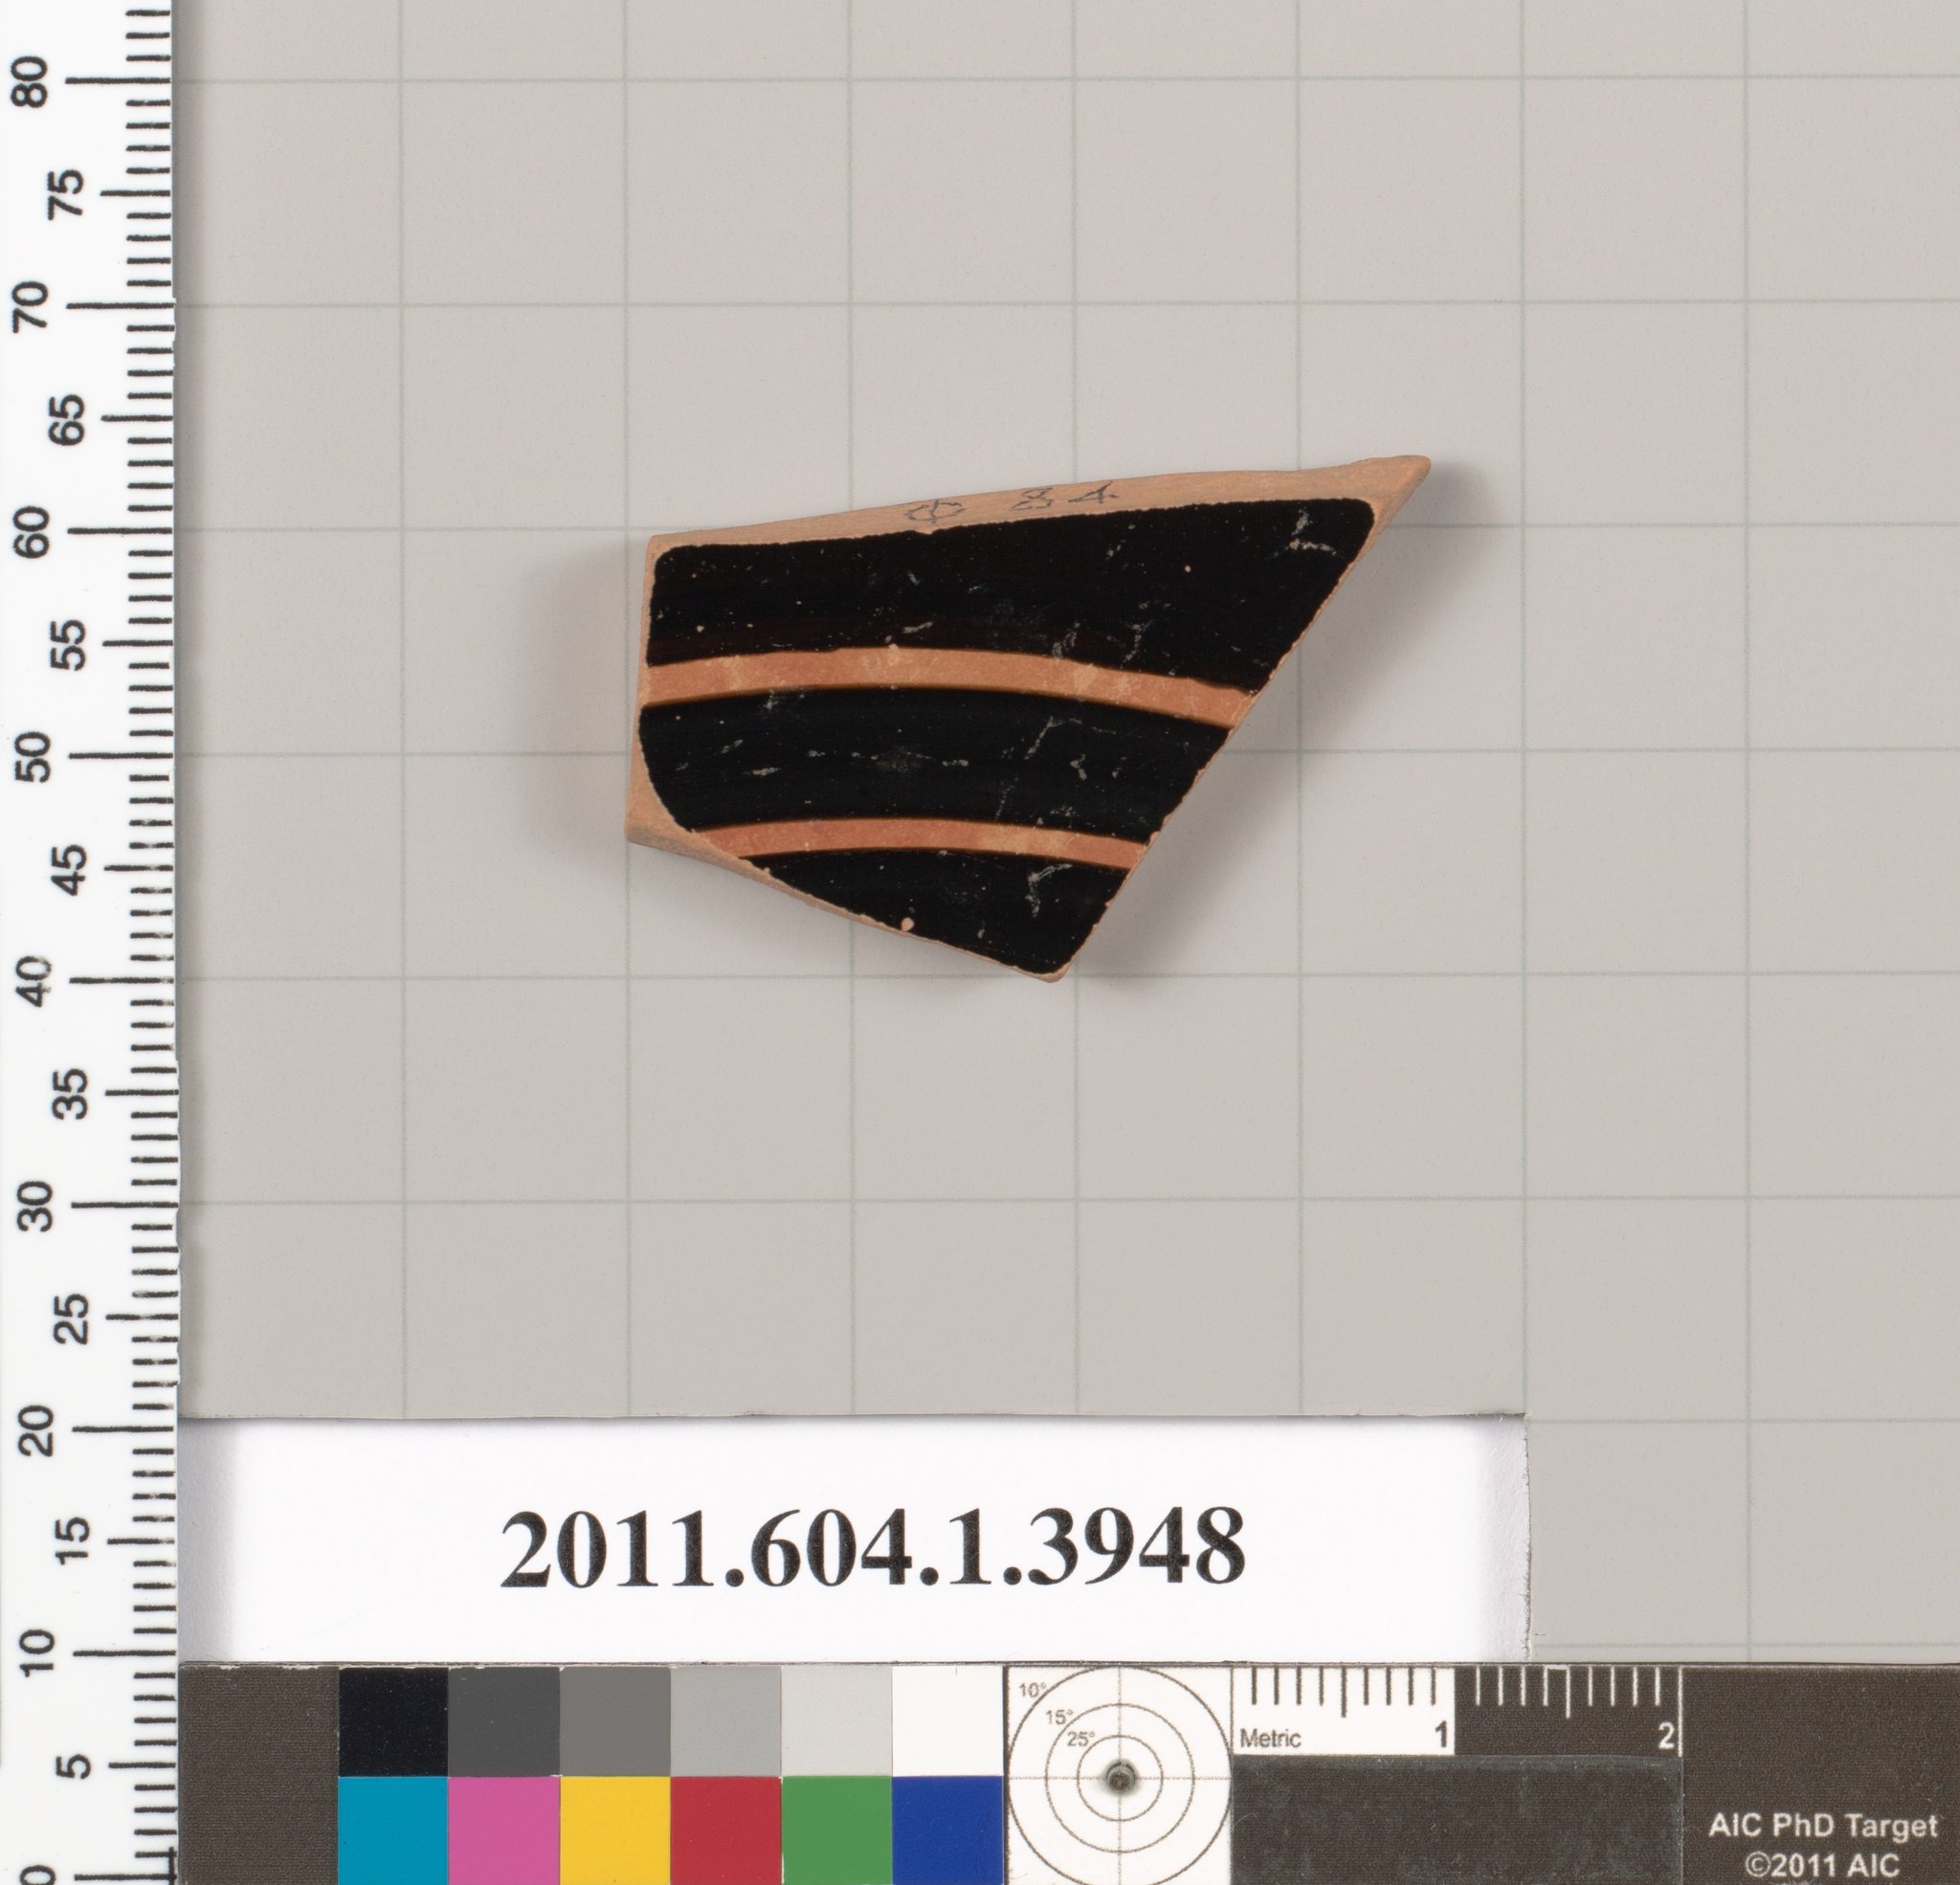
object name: kylix fragment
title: Terracotta fragment of a kylix (drinking cup)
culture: greek, attic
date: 500-476 BCE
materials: terracotta